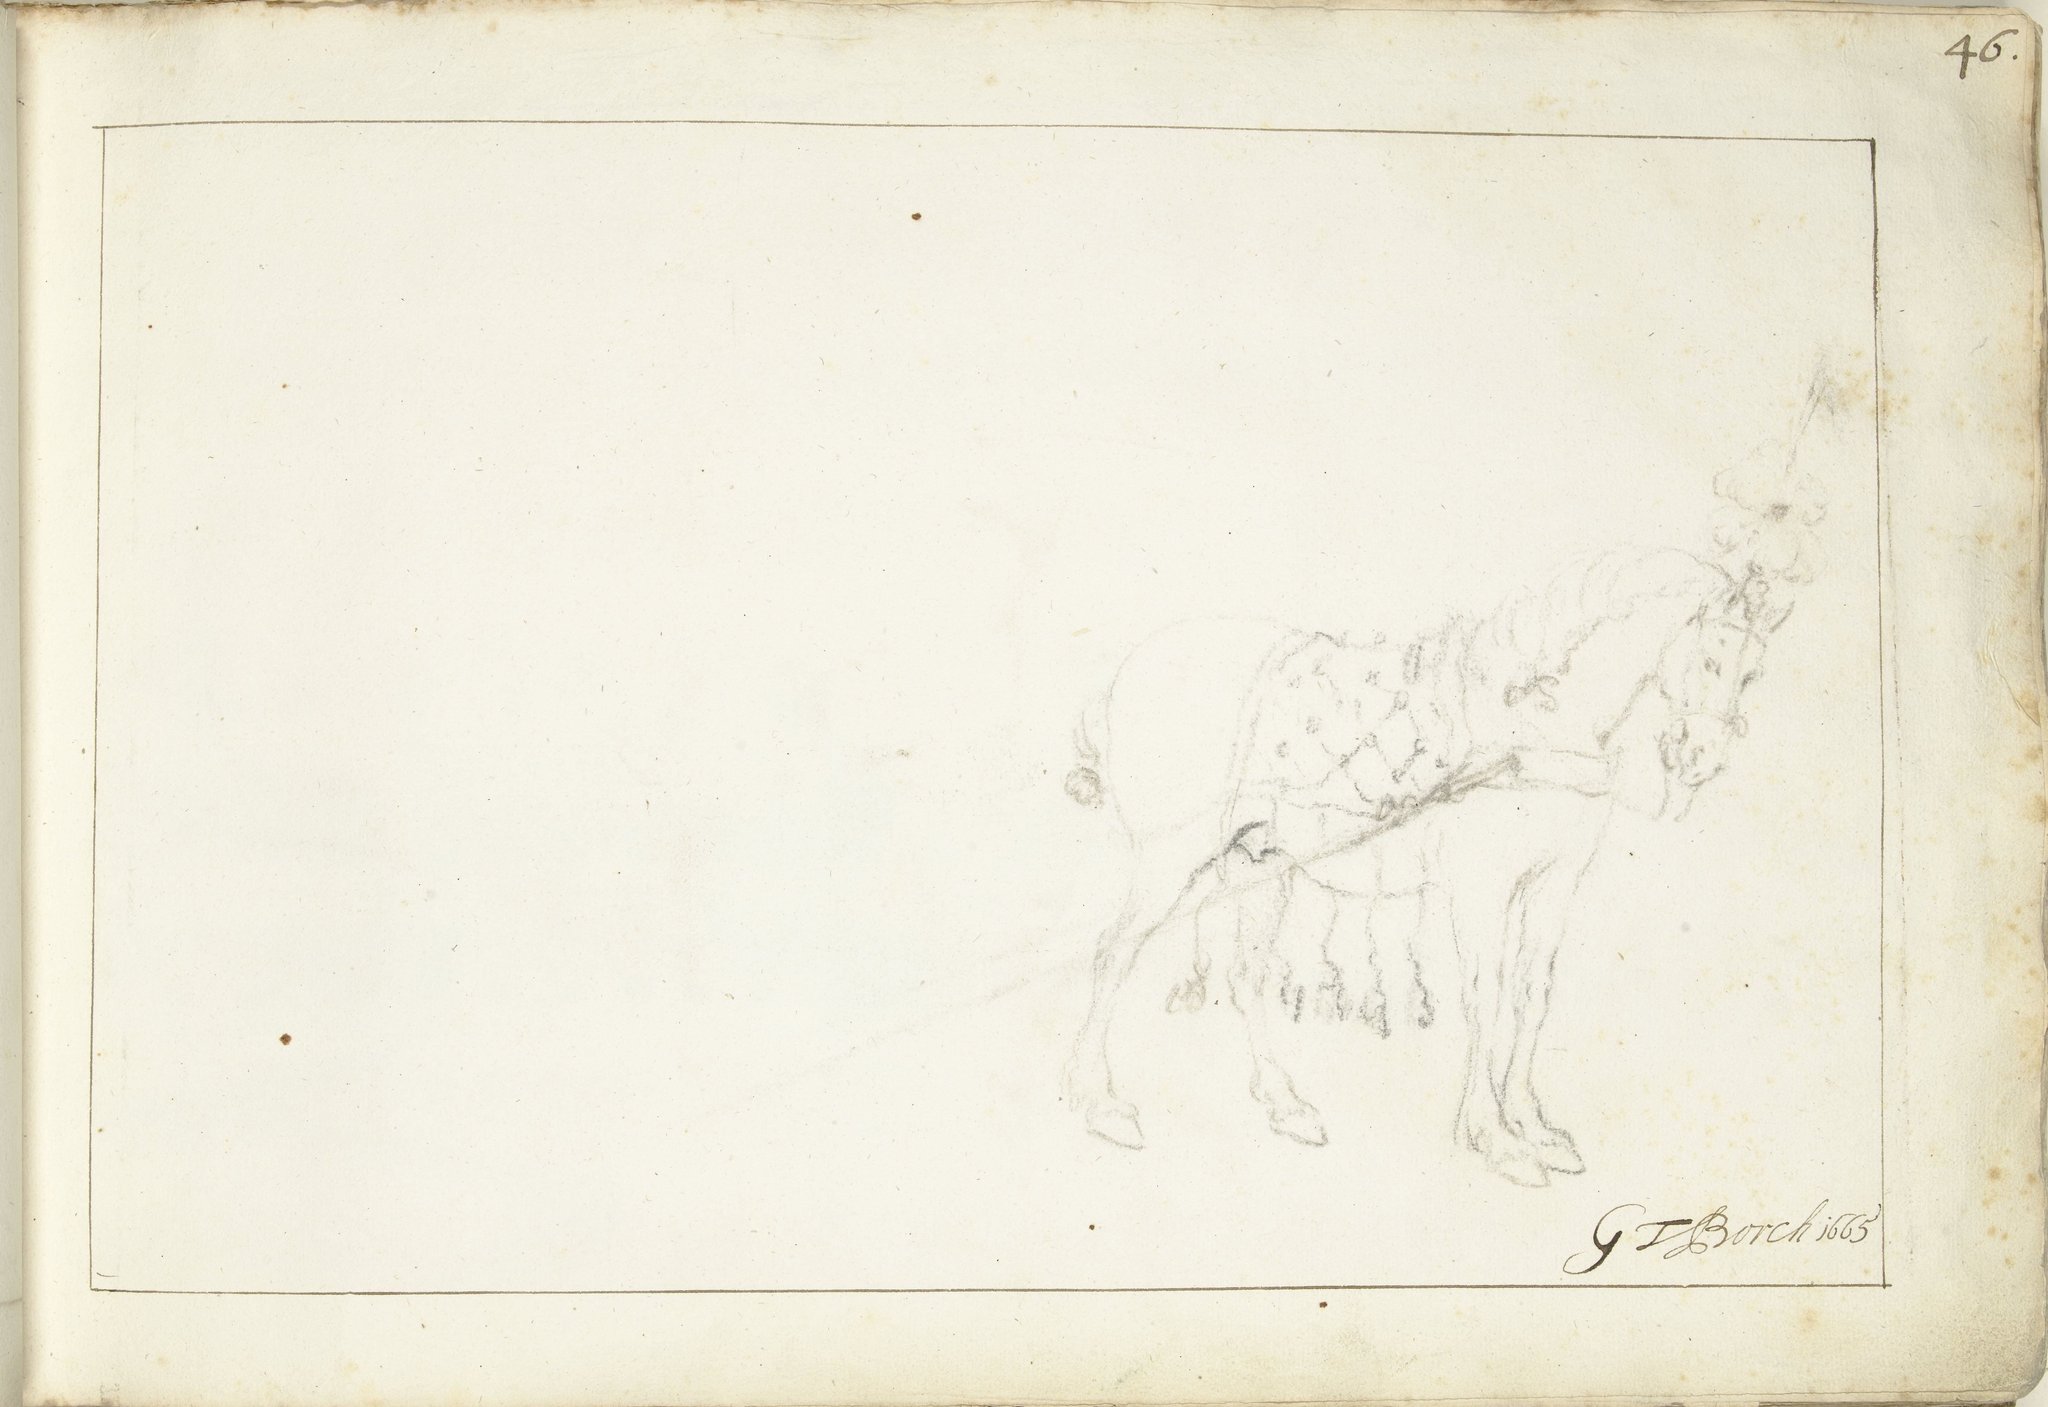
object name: drawing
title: Paard, naar rechts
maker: gerard ter borch (ii)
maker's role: draughtsman, painter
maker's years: 1617-1681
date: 1665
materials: chalk, paper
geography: deventer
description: Ongeveer hetzelfde paard als op folio 45 (BI-1887-1463-45) maar dan in spiegelbeeld.